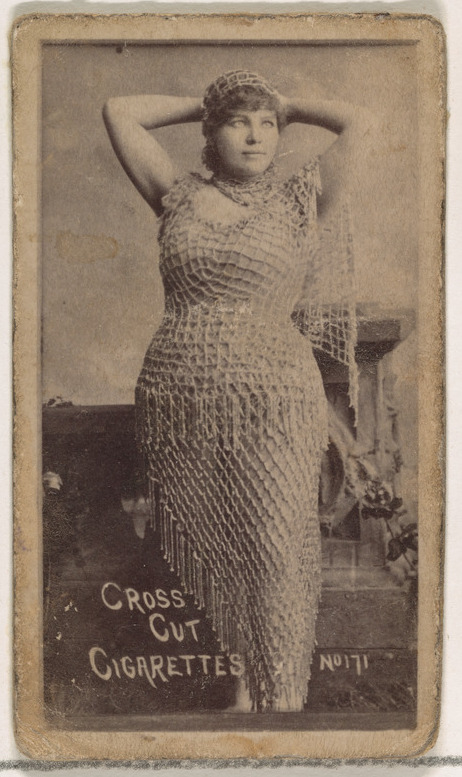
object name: print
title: Card Number 171, from the Actors and Actresses series (N145-1) issued by Duke Sons & Co. to promote Cross Cut Cigarettes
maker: w. duke, sons & co.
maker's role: publisher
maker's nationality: american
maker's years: 1870-1920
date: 1880-1889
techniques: albumen silver print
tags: portraits,women,actresses